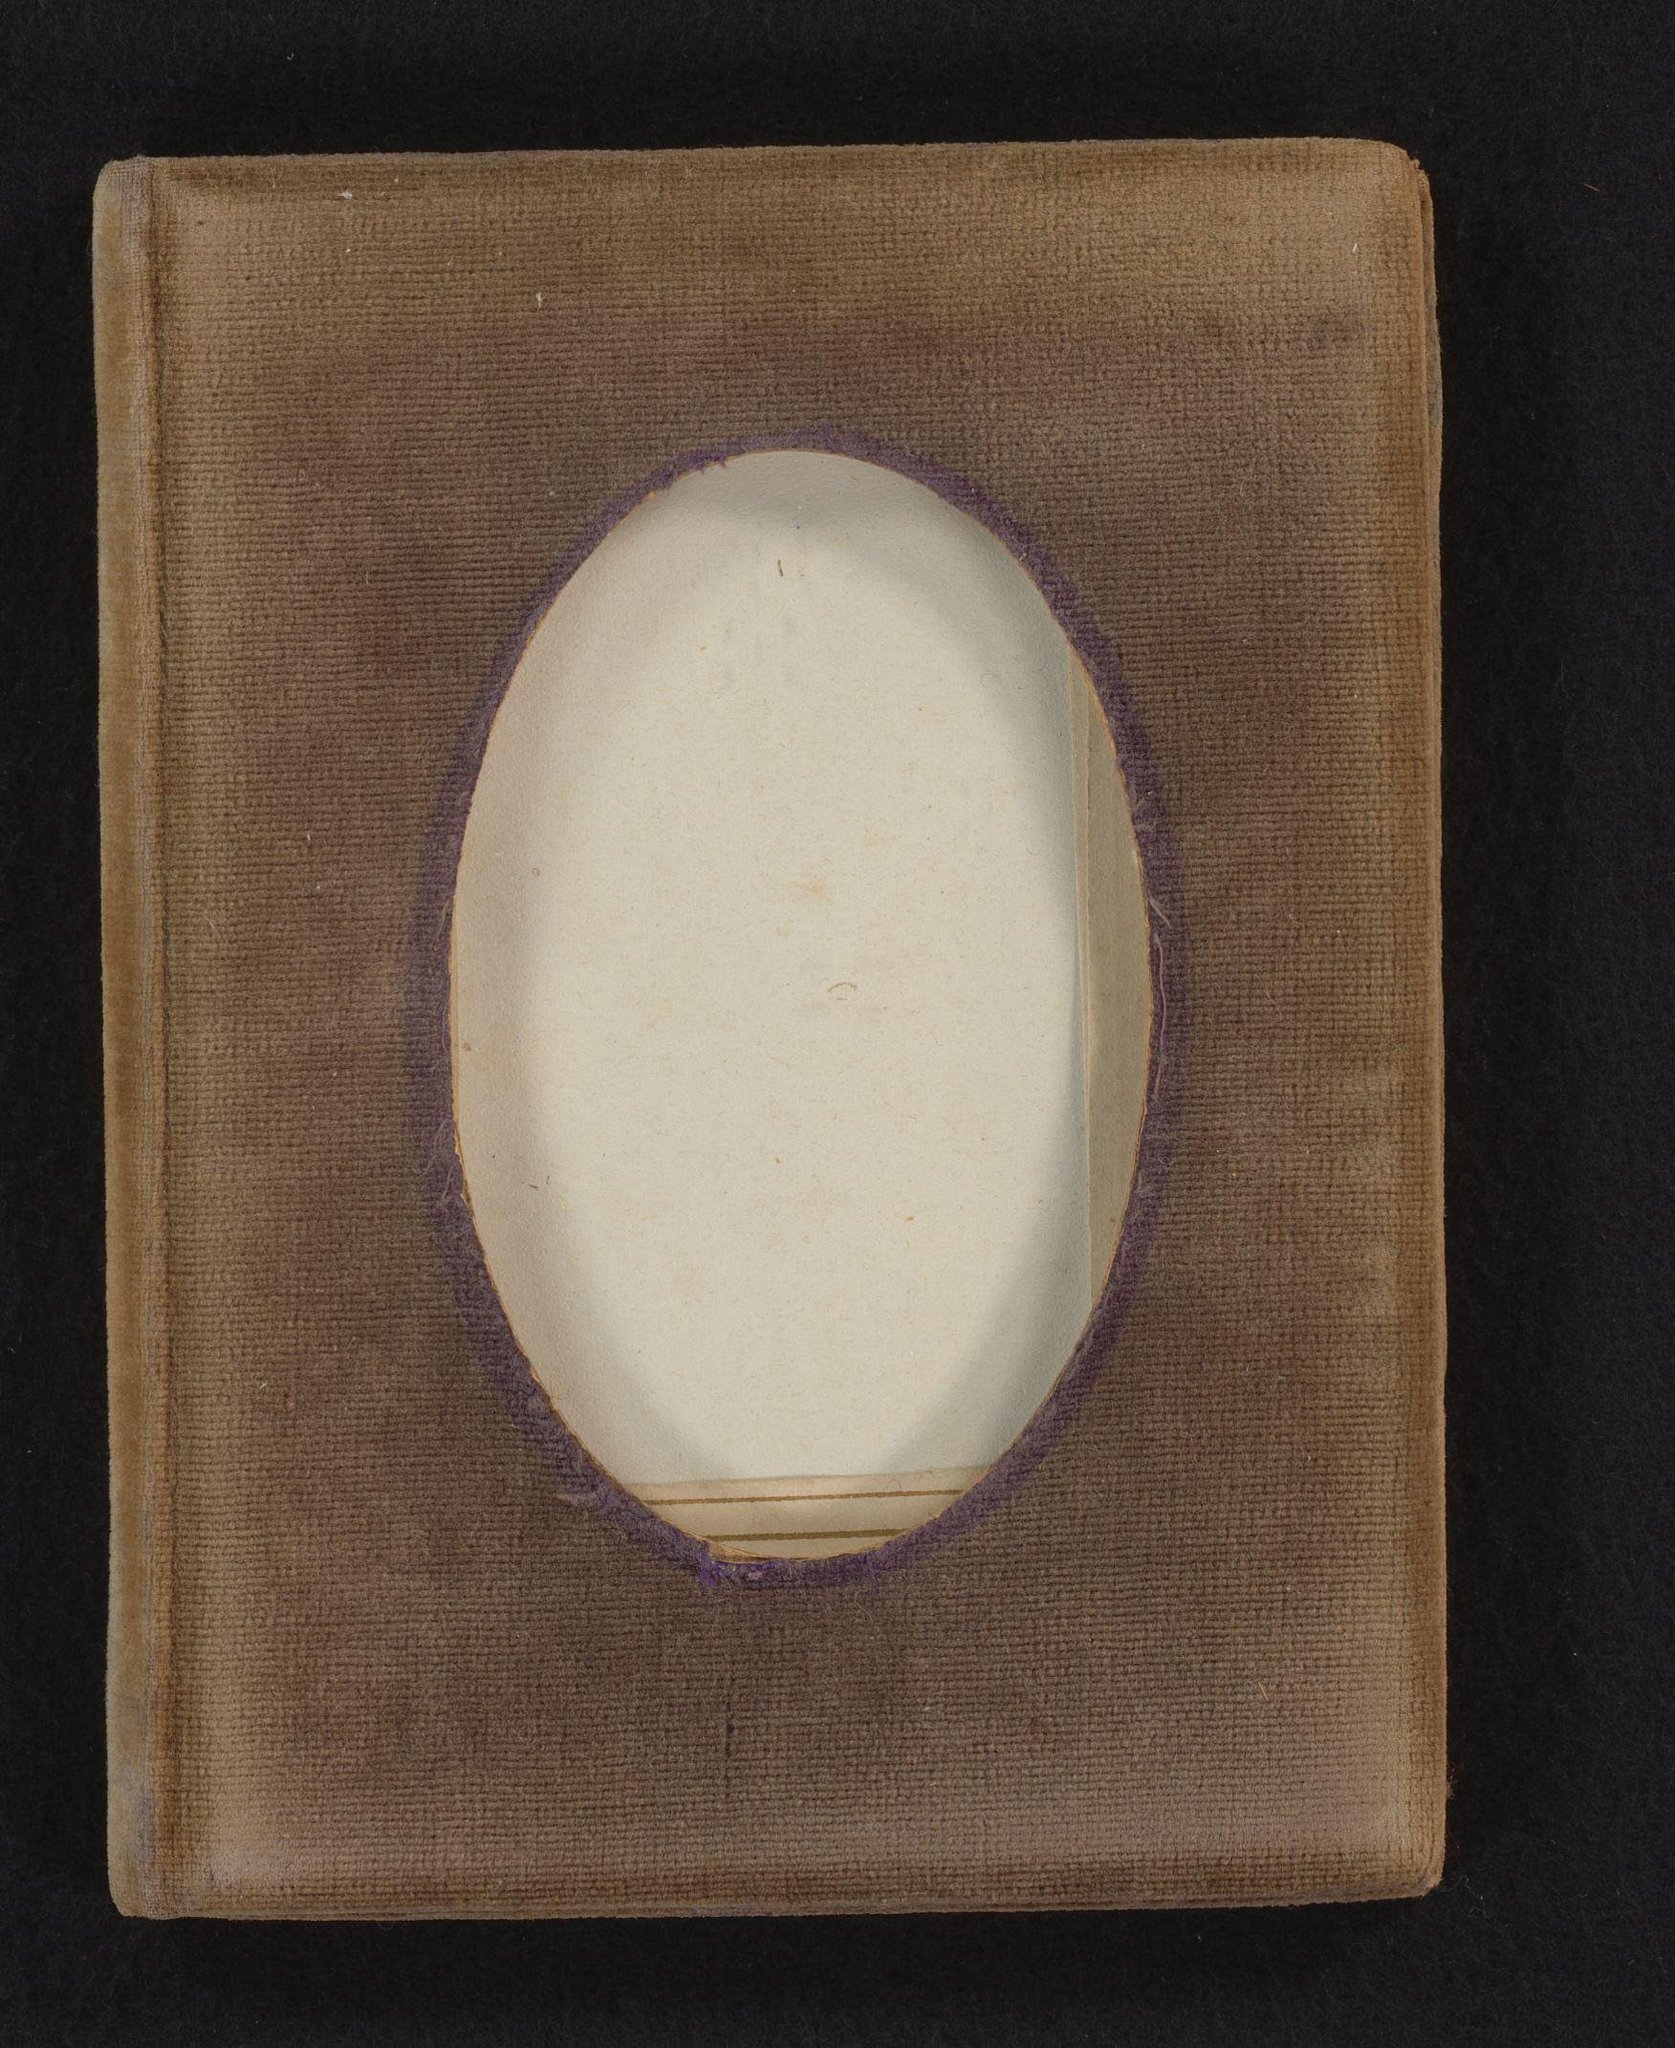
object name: slip in album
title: Fotoalbum (leeg)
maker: Anonymous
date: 1860-1900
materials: cardboard, glass, paper, textile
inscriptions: collector's mark: ‘DIENST/ VERSPREIDE/ RIJKSKOLLEKTIES/ (...) A 775’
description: Fotoalbum in de vorm van een uitklapbare driedelige map met passe-partouts voor vier cartes-de-visite.